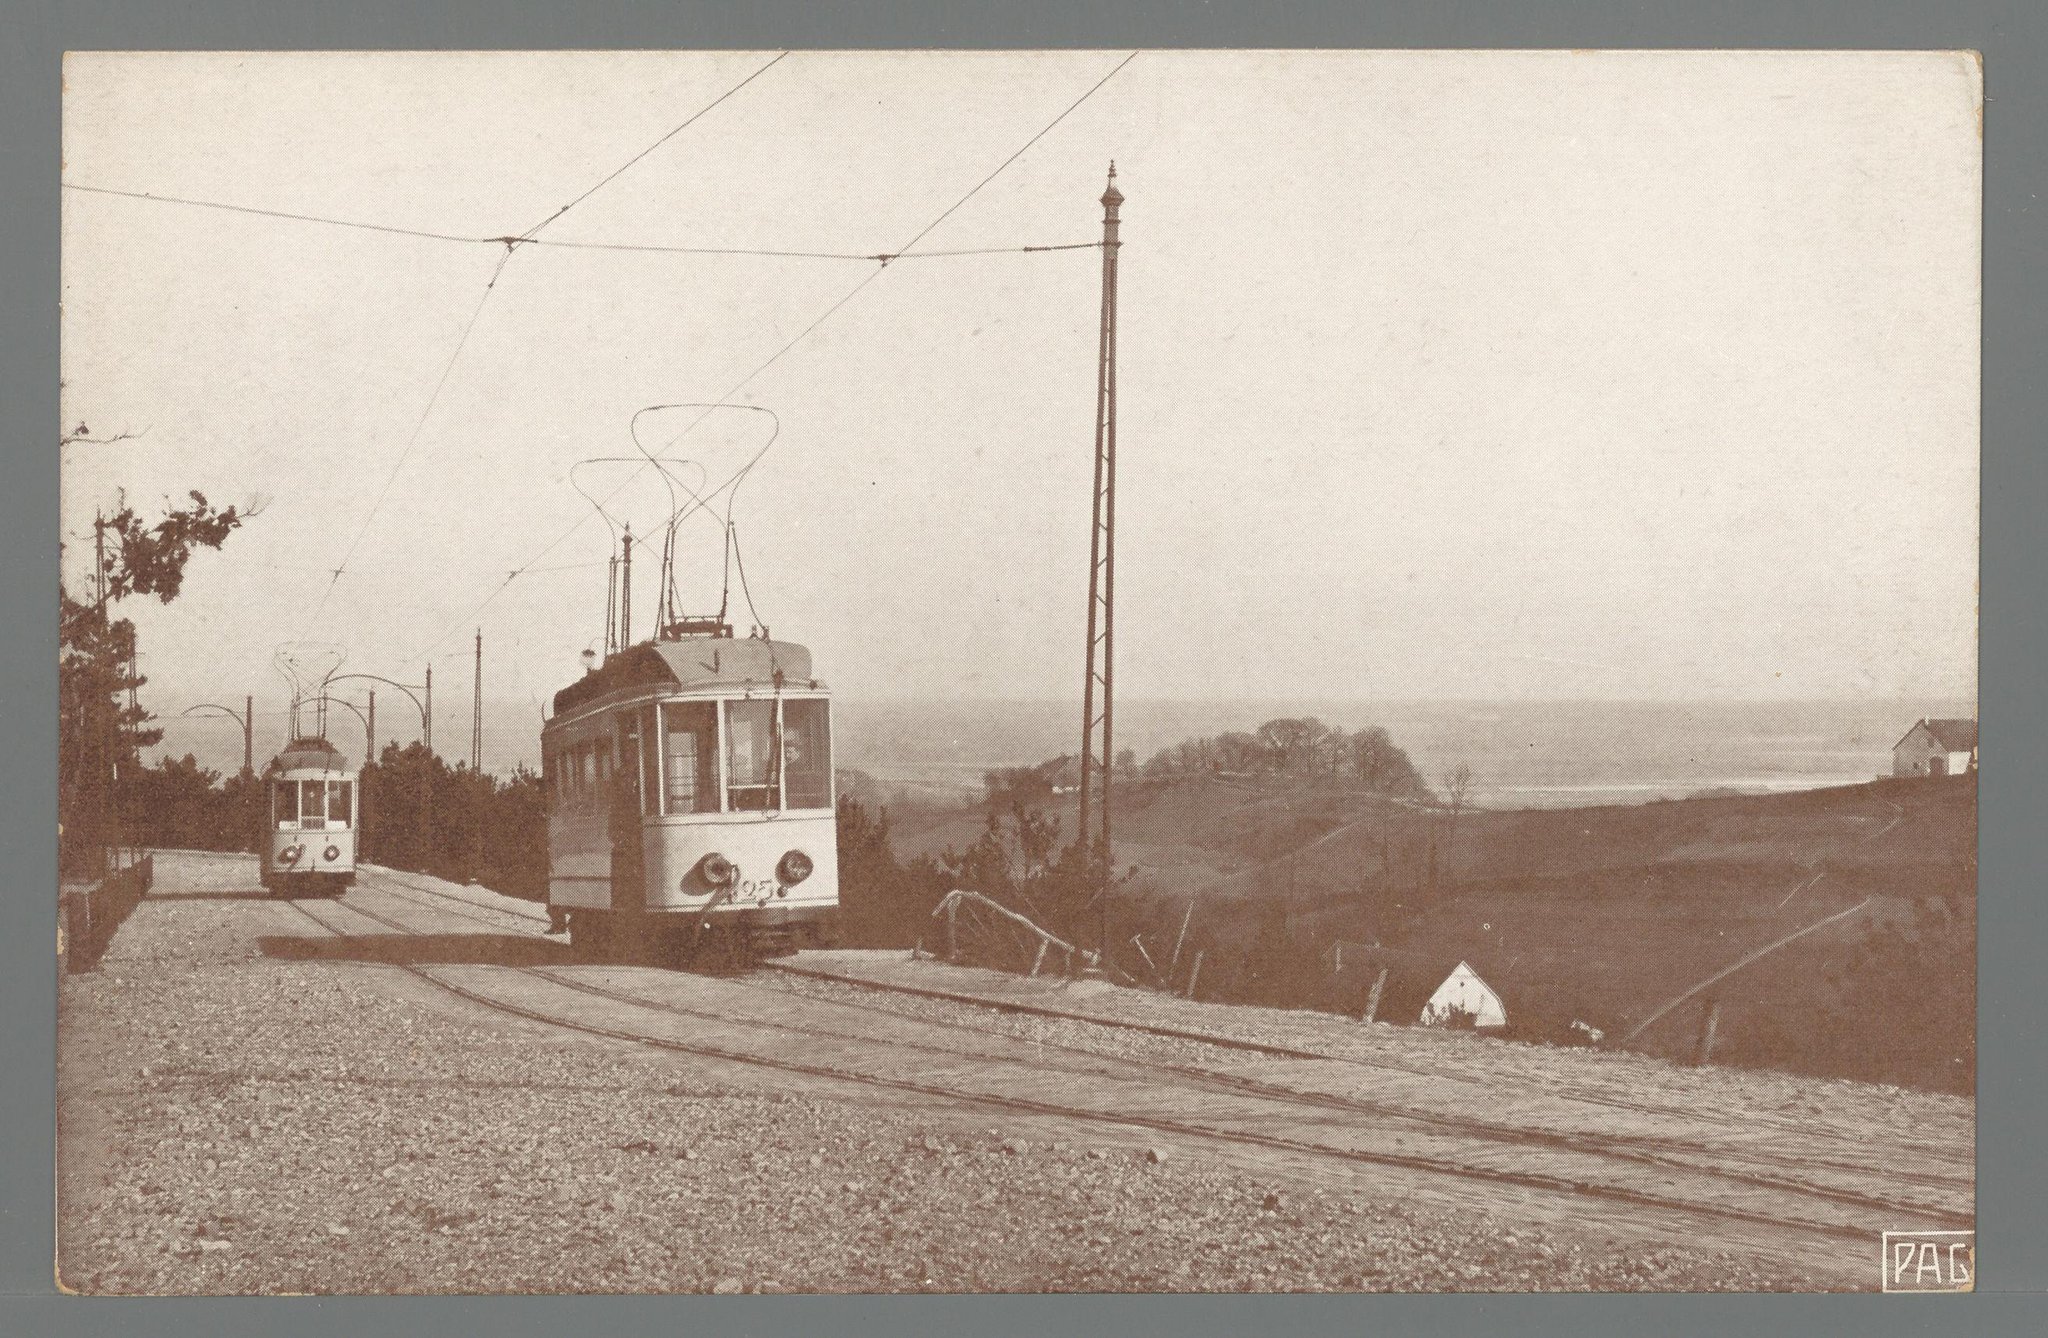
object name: ansichtkaart, prentbriefkaart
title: Langs de Duitsche grens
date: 1905-1930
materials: cardboard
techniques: writing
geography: berg en dal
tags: tram, tramway, tram